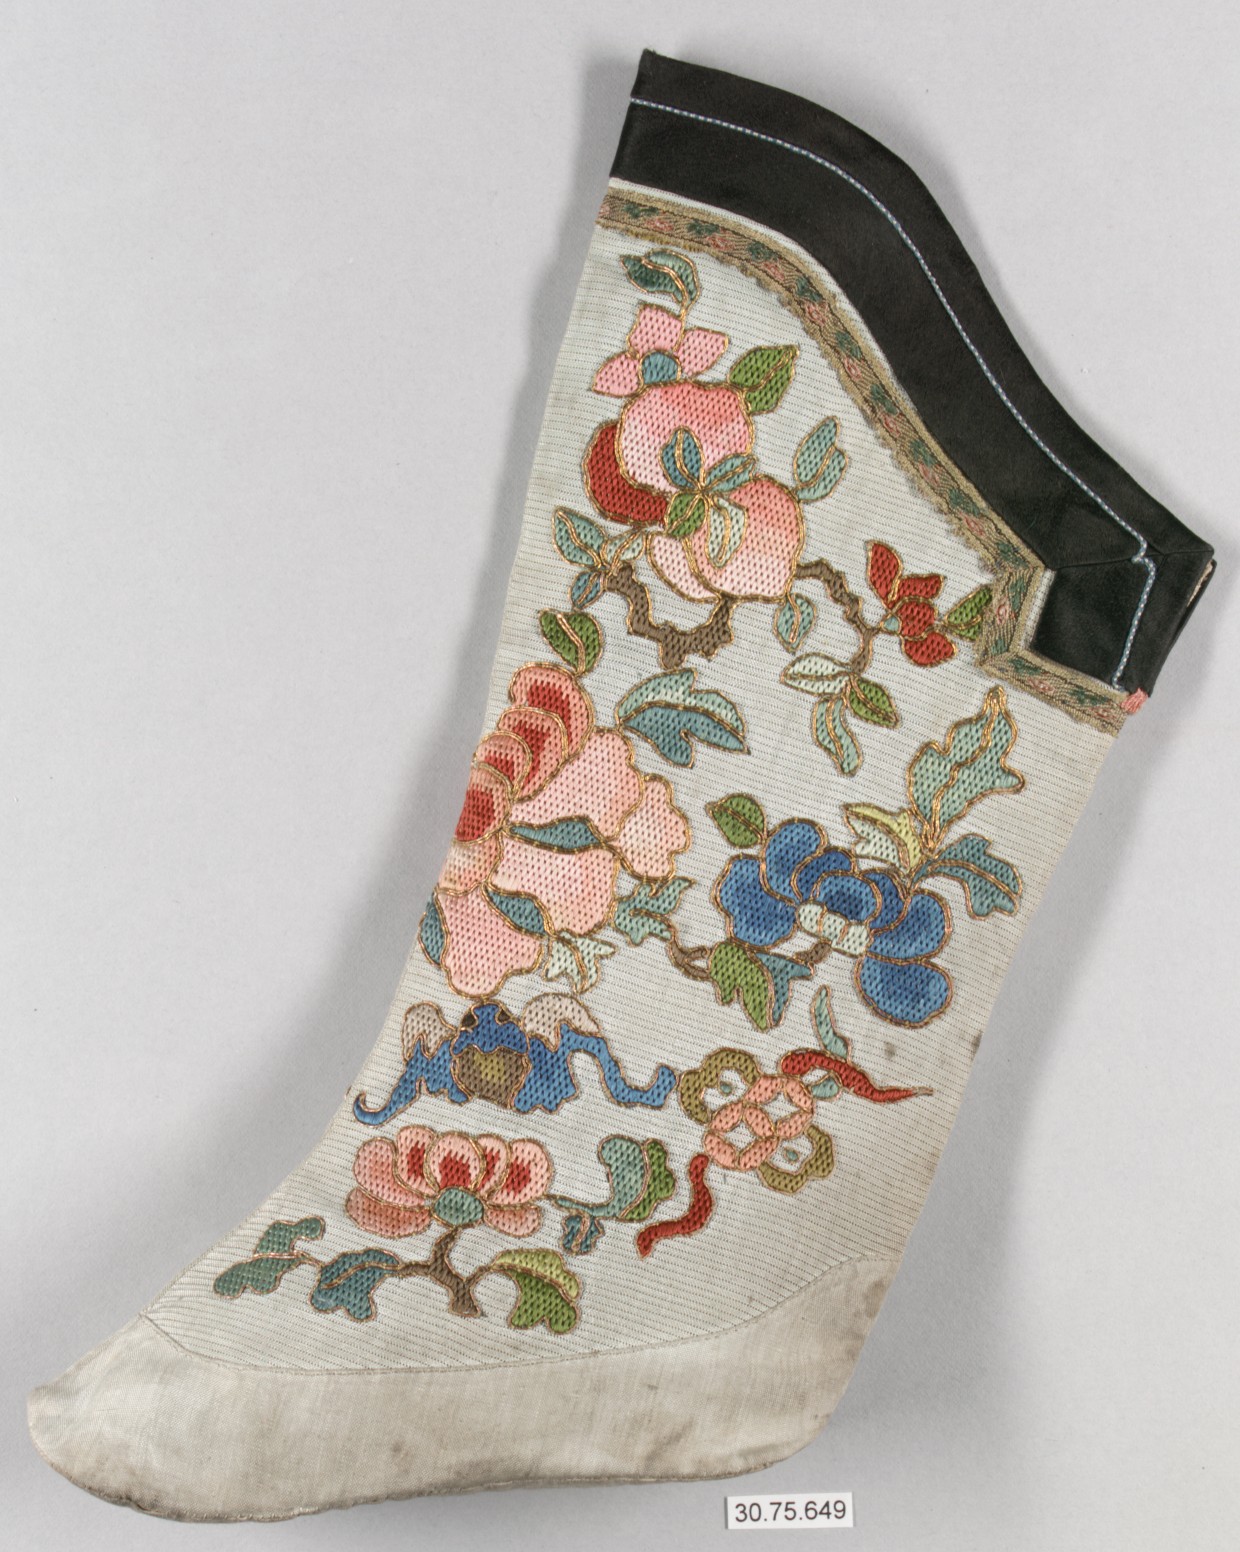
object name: boot, child's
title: Child's Boot (one of a pair)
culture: chinese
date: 1701-1900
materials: silk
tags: flowers